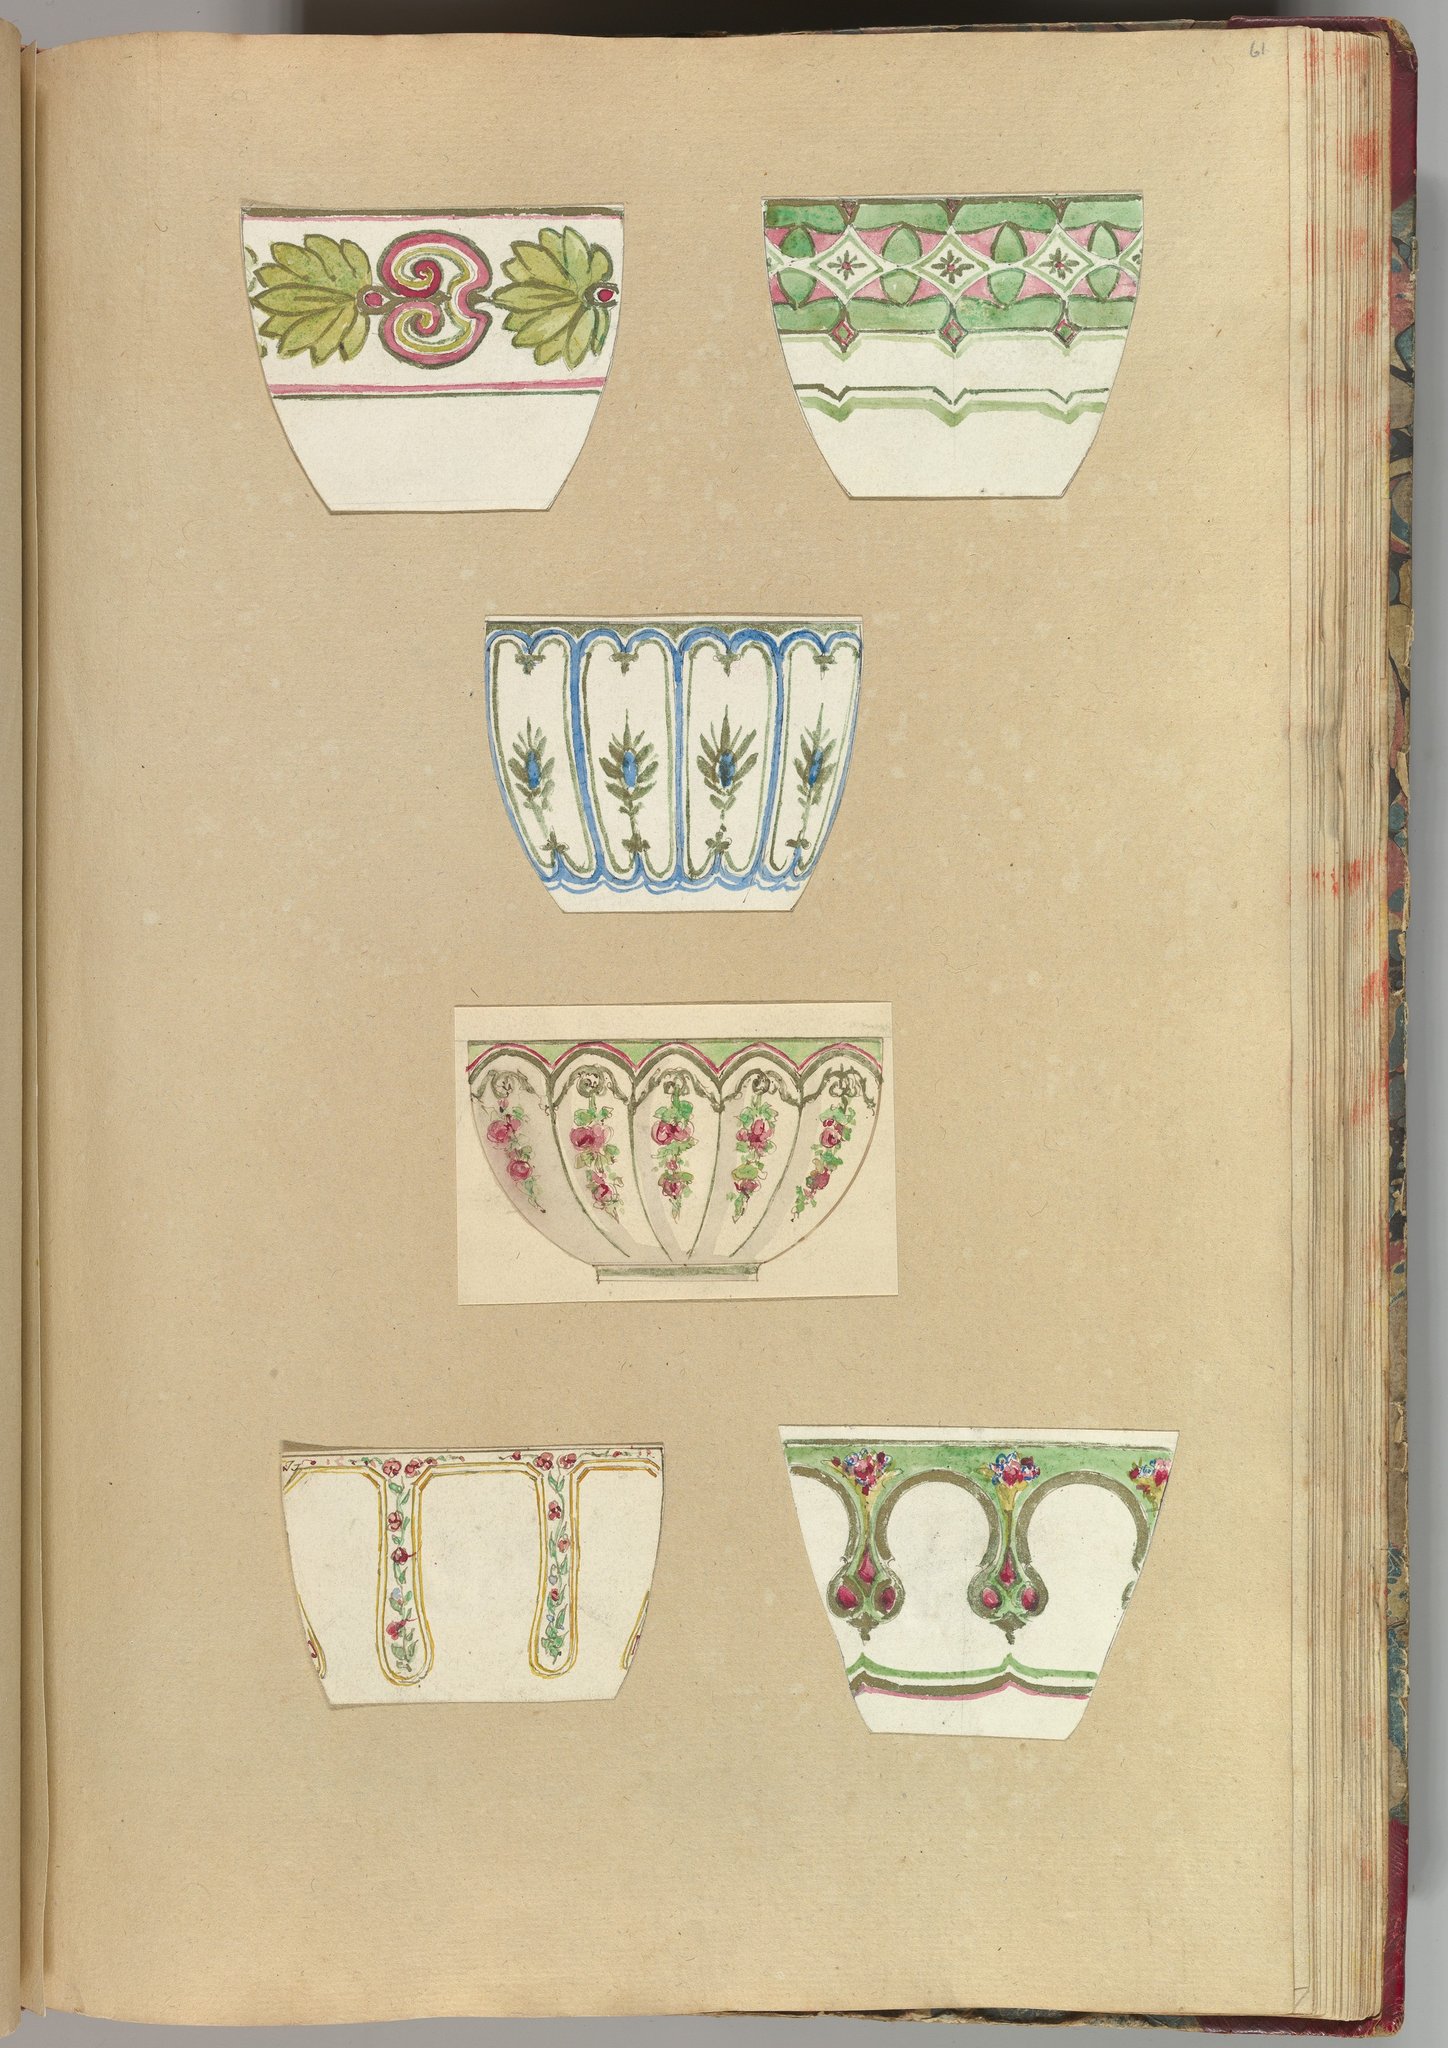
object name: drawing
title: Six Designs for Decorated Cups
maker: alfred henry forrester [alfred crowquill]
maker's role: artist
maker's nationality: british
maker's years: 1804-1872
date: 1845-1855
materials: ink, watercolor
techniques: pen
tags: cups